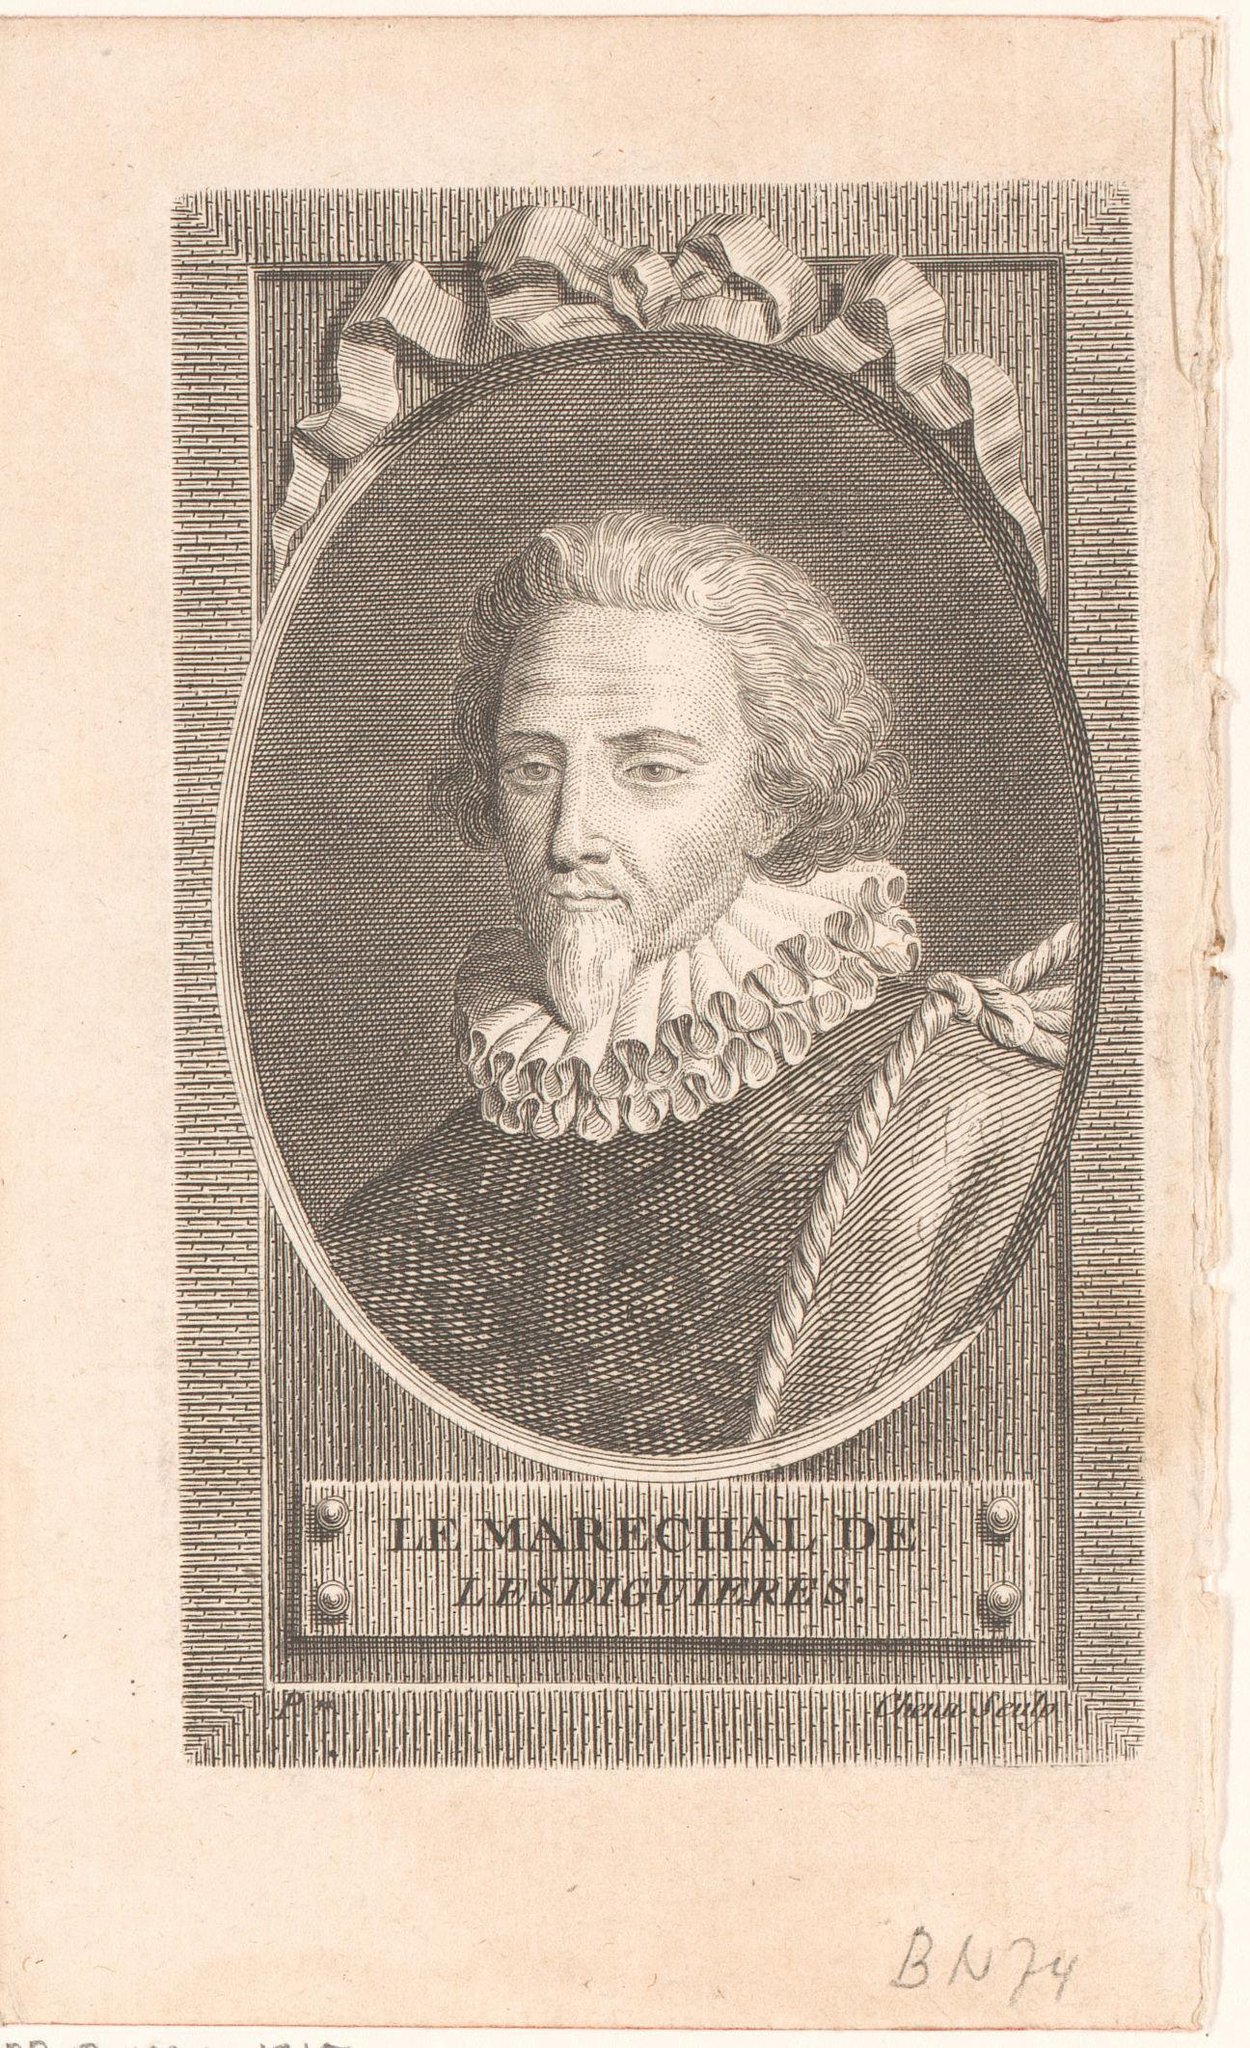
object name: book illustration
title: Portret van François de Bonne hertog van Lesdiguières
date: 1766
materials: paper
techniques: etching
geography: france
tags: historical persons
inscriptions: collector's mark: Lugt 2228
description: Prent uit: Bury, Richard de. Histoire de la vie de Henri IV, roi de France et de Navarre (...). Parijs: Saillant, Charles, 1766.